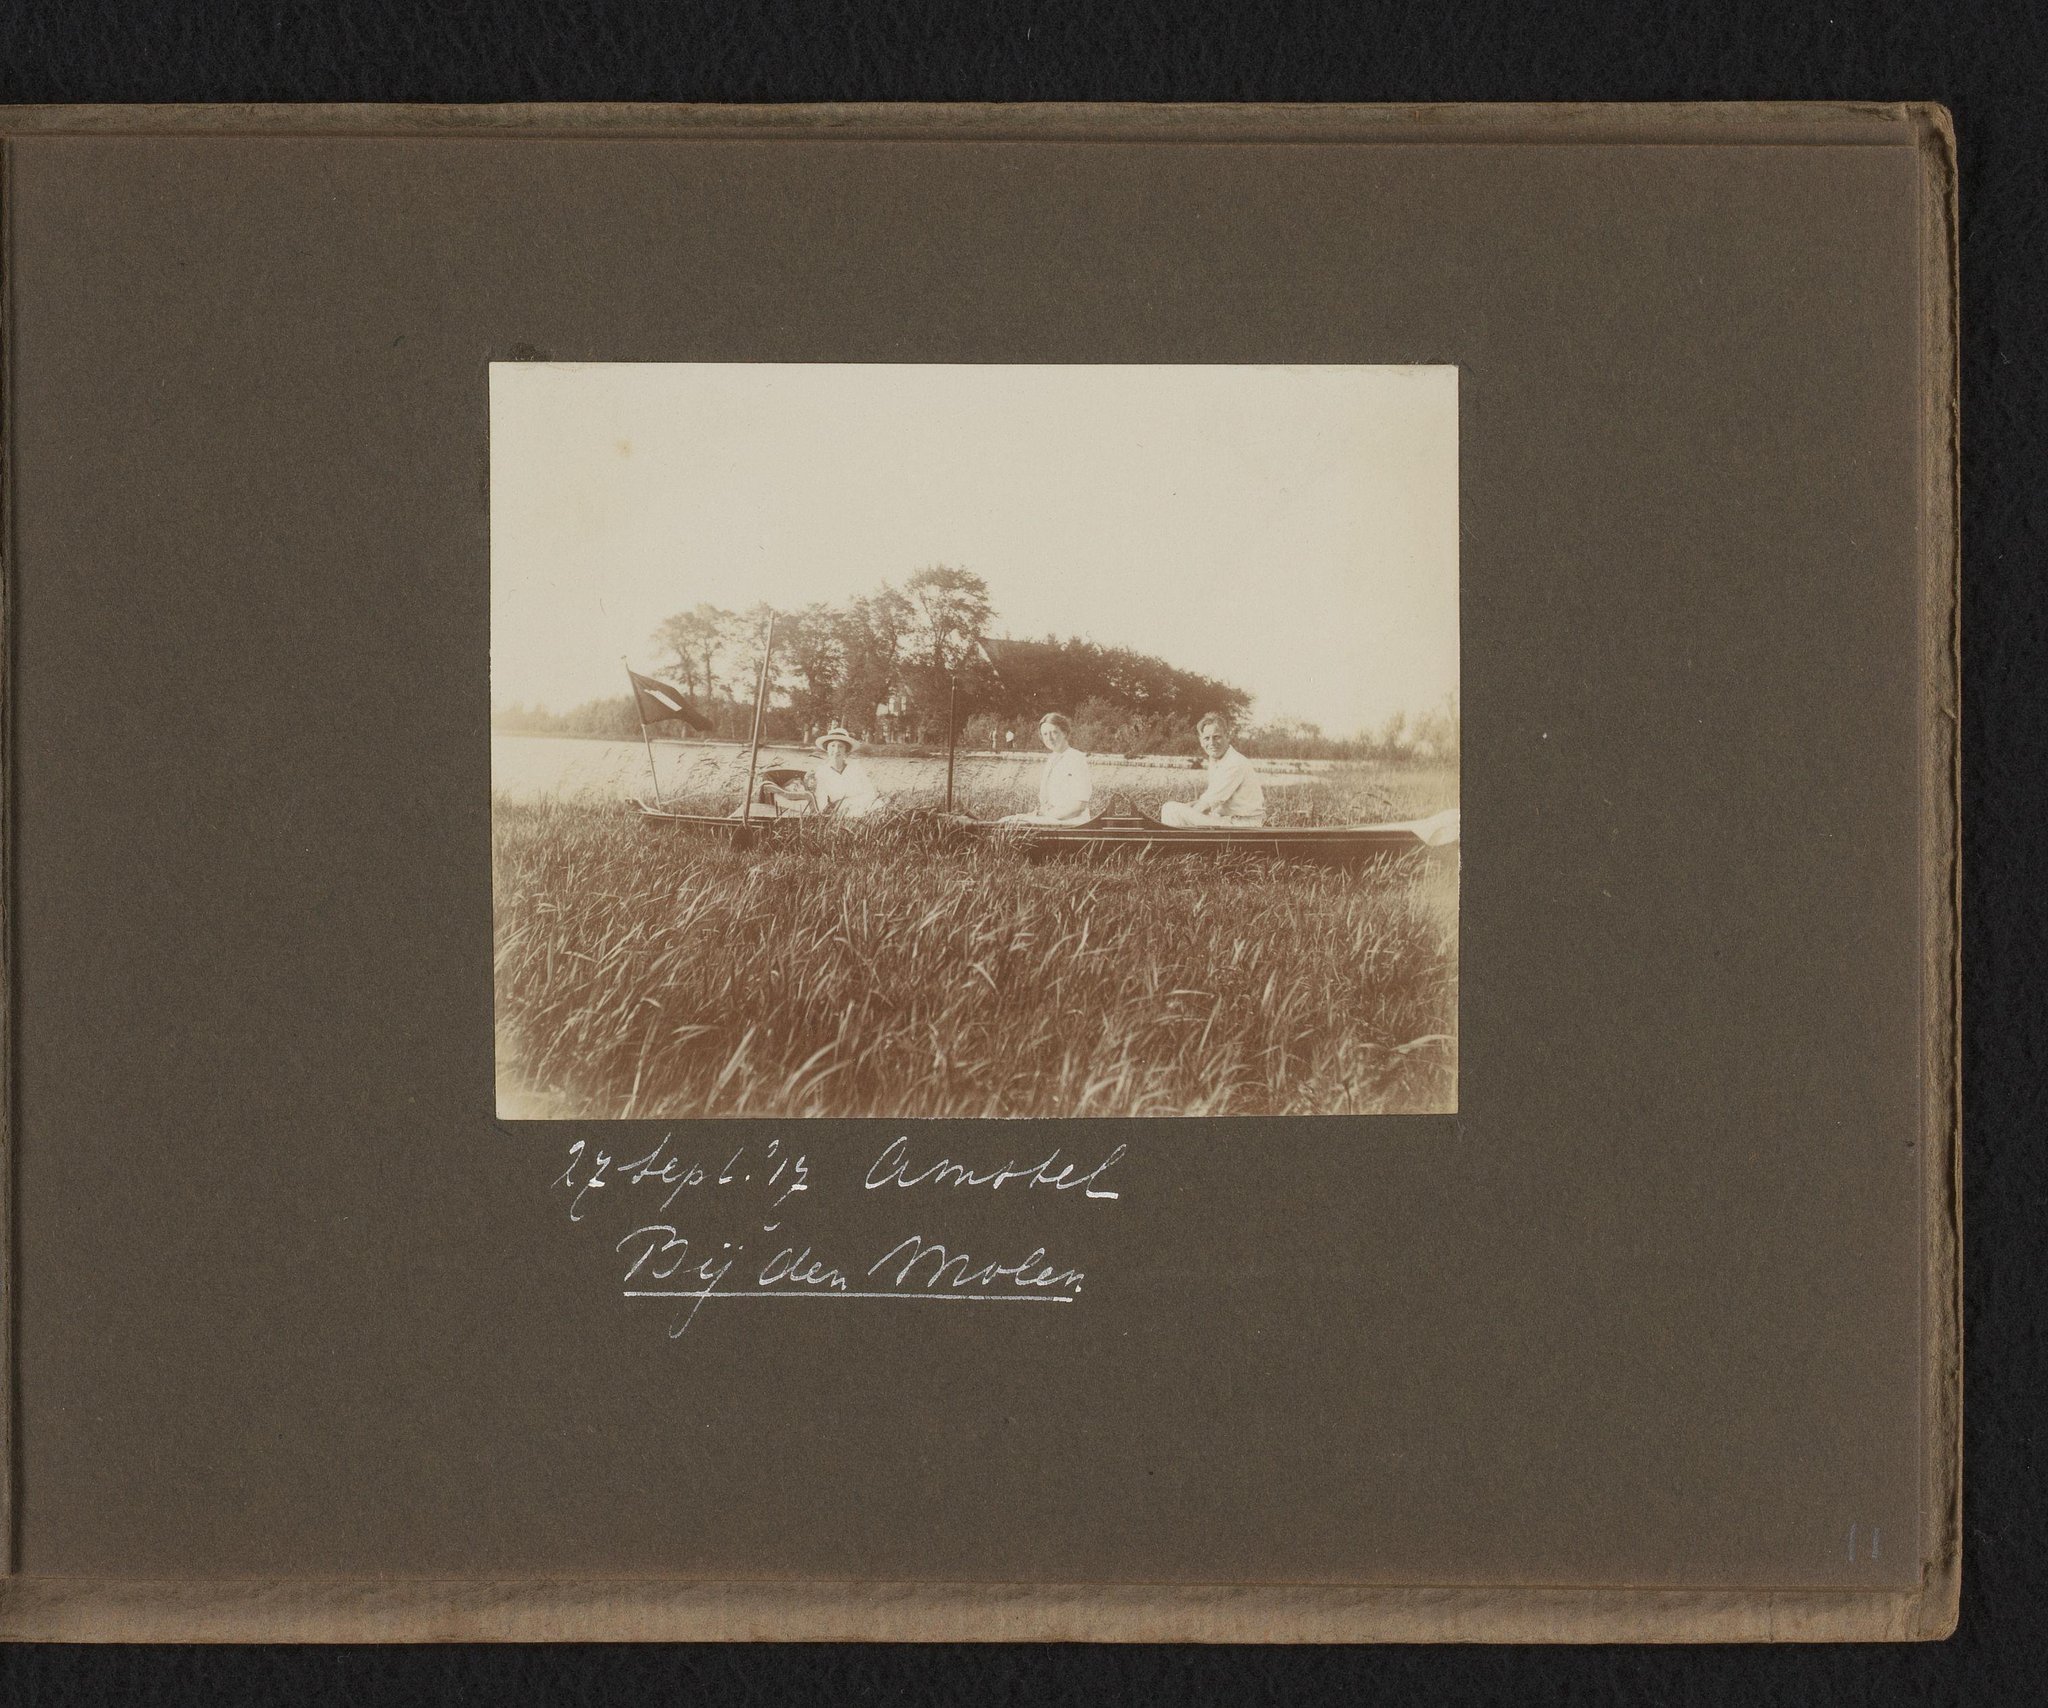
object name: photograph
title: Twee vrouwen en een man in een boot tussen het riet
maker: Anonymous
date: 1917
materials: paper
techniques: matte daylight collodion silver print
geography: amstel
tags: adult man, rowing-boat, canoe, etc., plants and herbs: reed, adult woman (+ two persons)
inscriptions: caption: ‘Amstel/ Bij den Molen.’